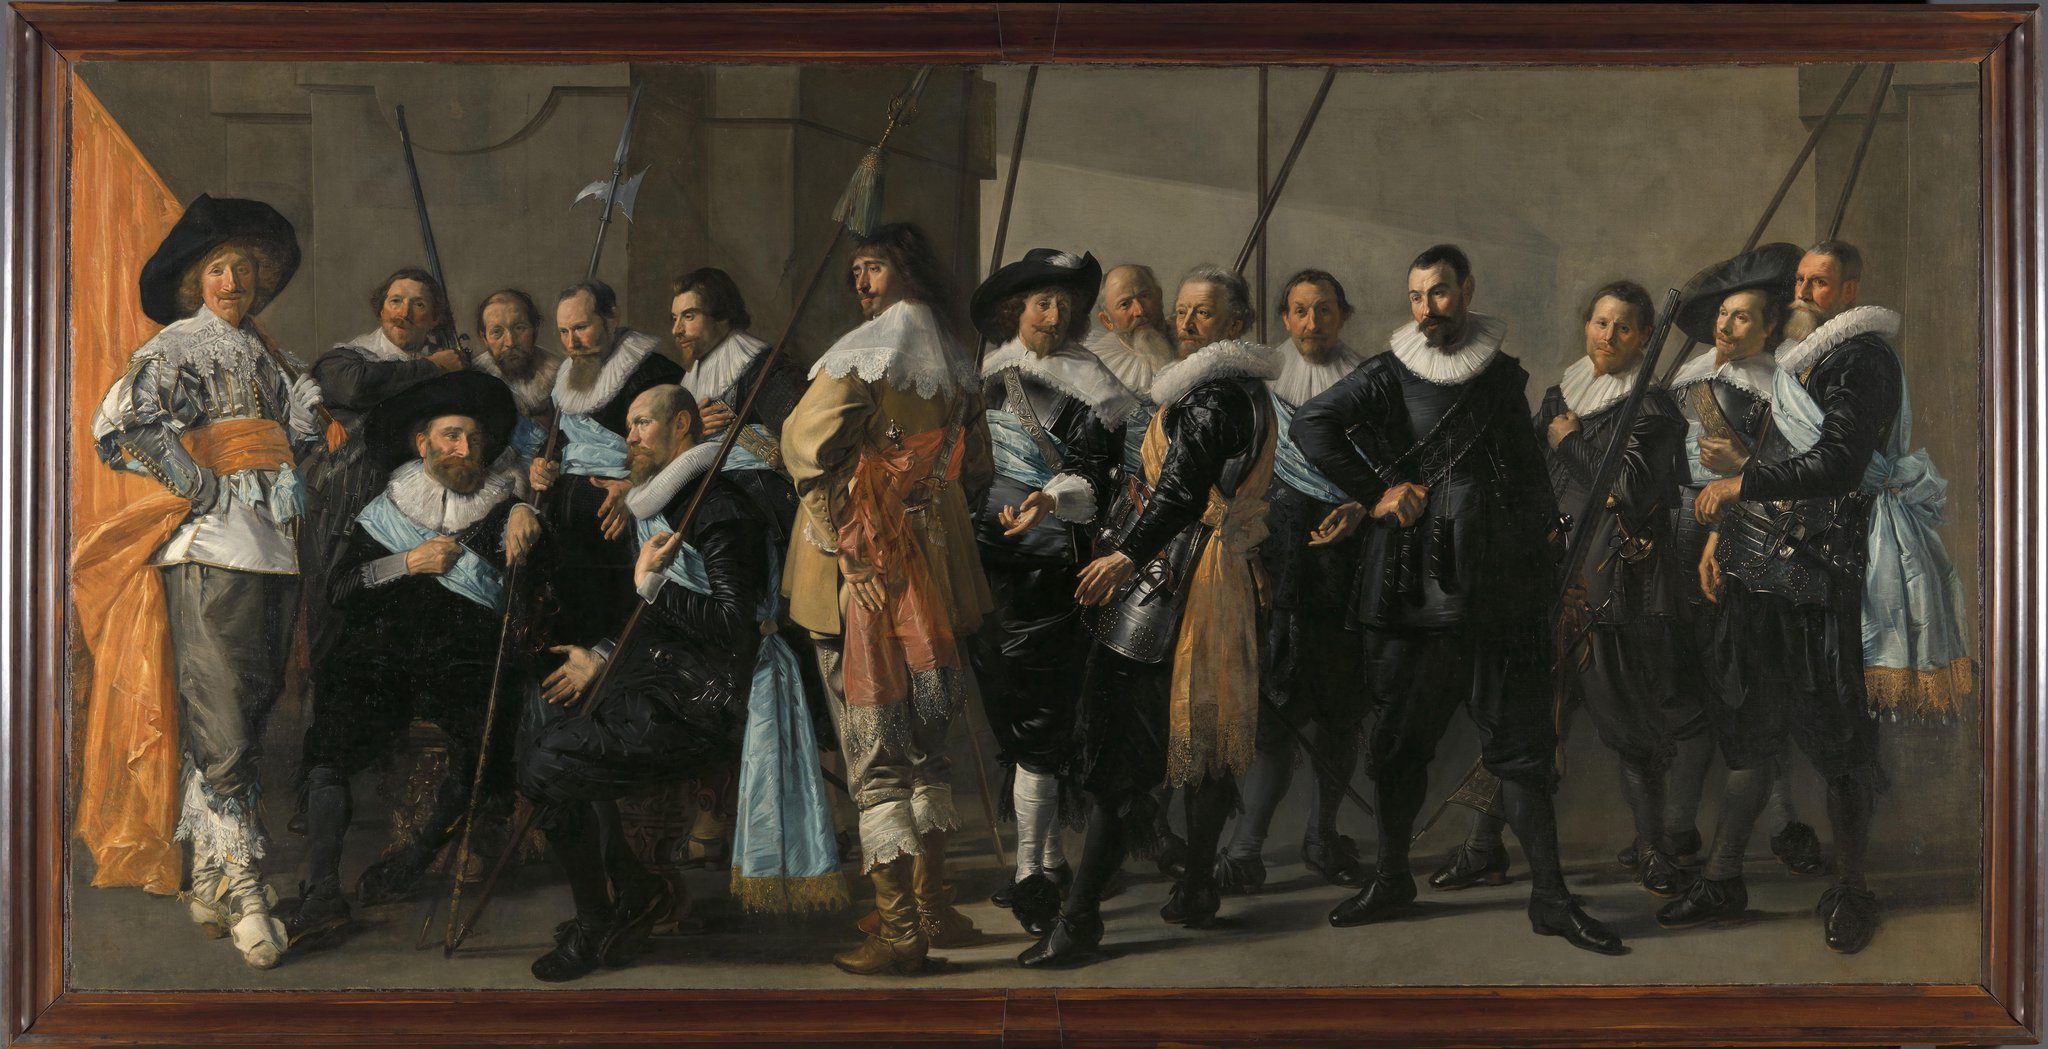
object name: painting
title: Militia Company of District XI under the Command of Captain Reynier Reael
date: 1637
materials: canvas, oil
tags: amsterdam, warfare; military affairs (+ citizen soldiery, civil guard, citizen militia)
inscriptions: date, centre right: ‘Aº 1637’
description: So much went wrong with this Amsterdam militia company portrait. Hals made several trips to the capital to portray the guardsmen, but some never showed up. Finally, he insisted they come to Haarlem, but they refused, instead engaging the Amsterdam painter Pieter Codde to complete the work. Hals’ progress then remains unclear, but the composition and the seven figures on the left seem to be largely by him.